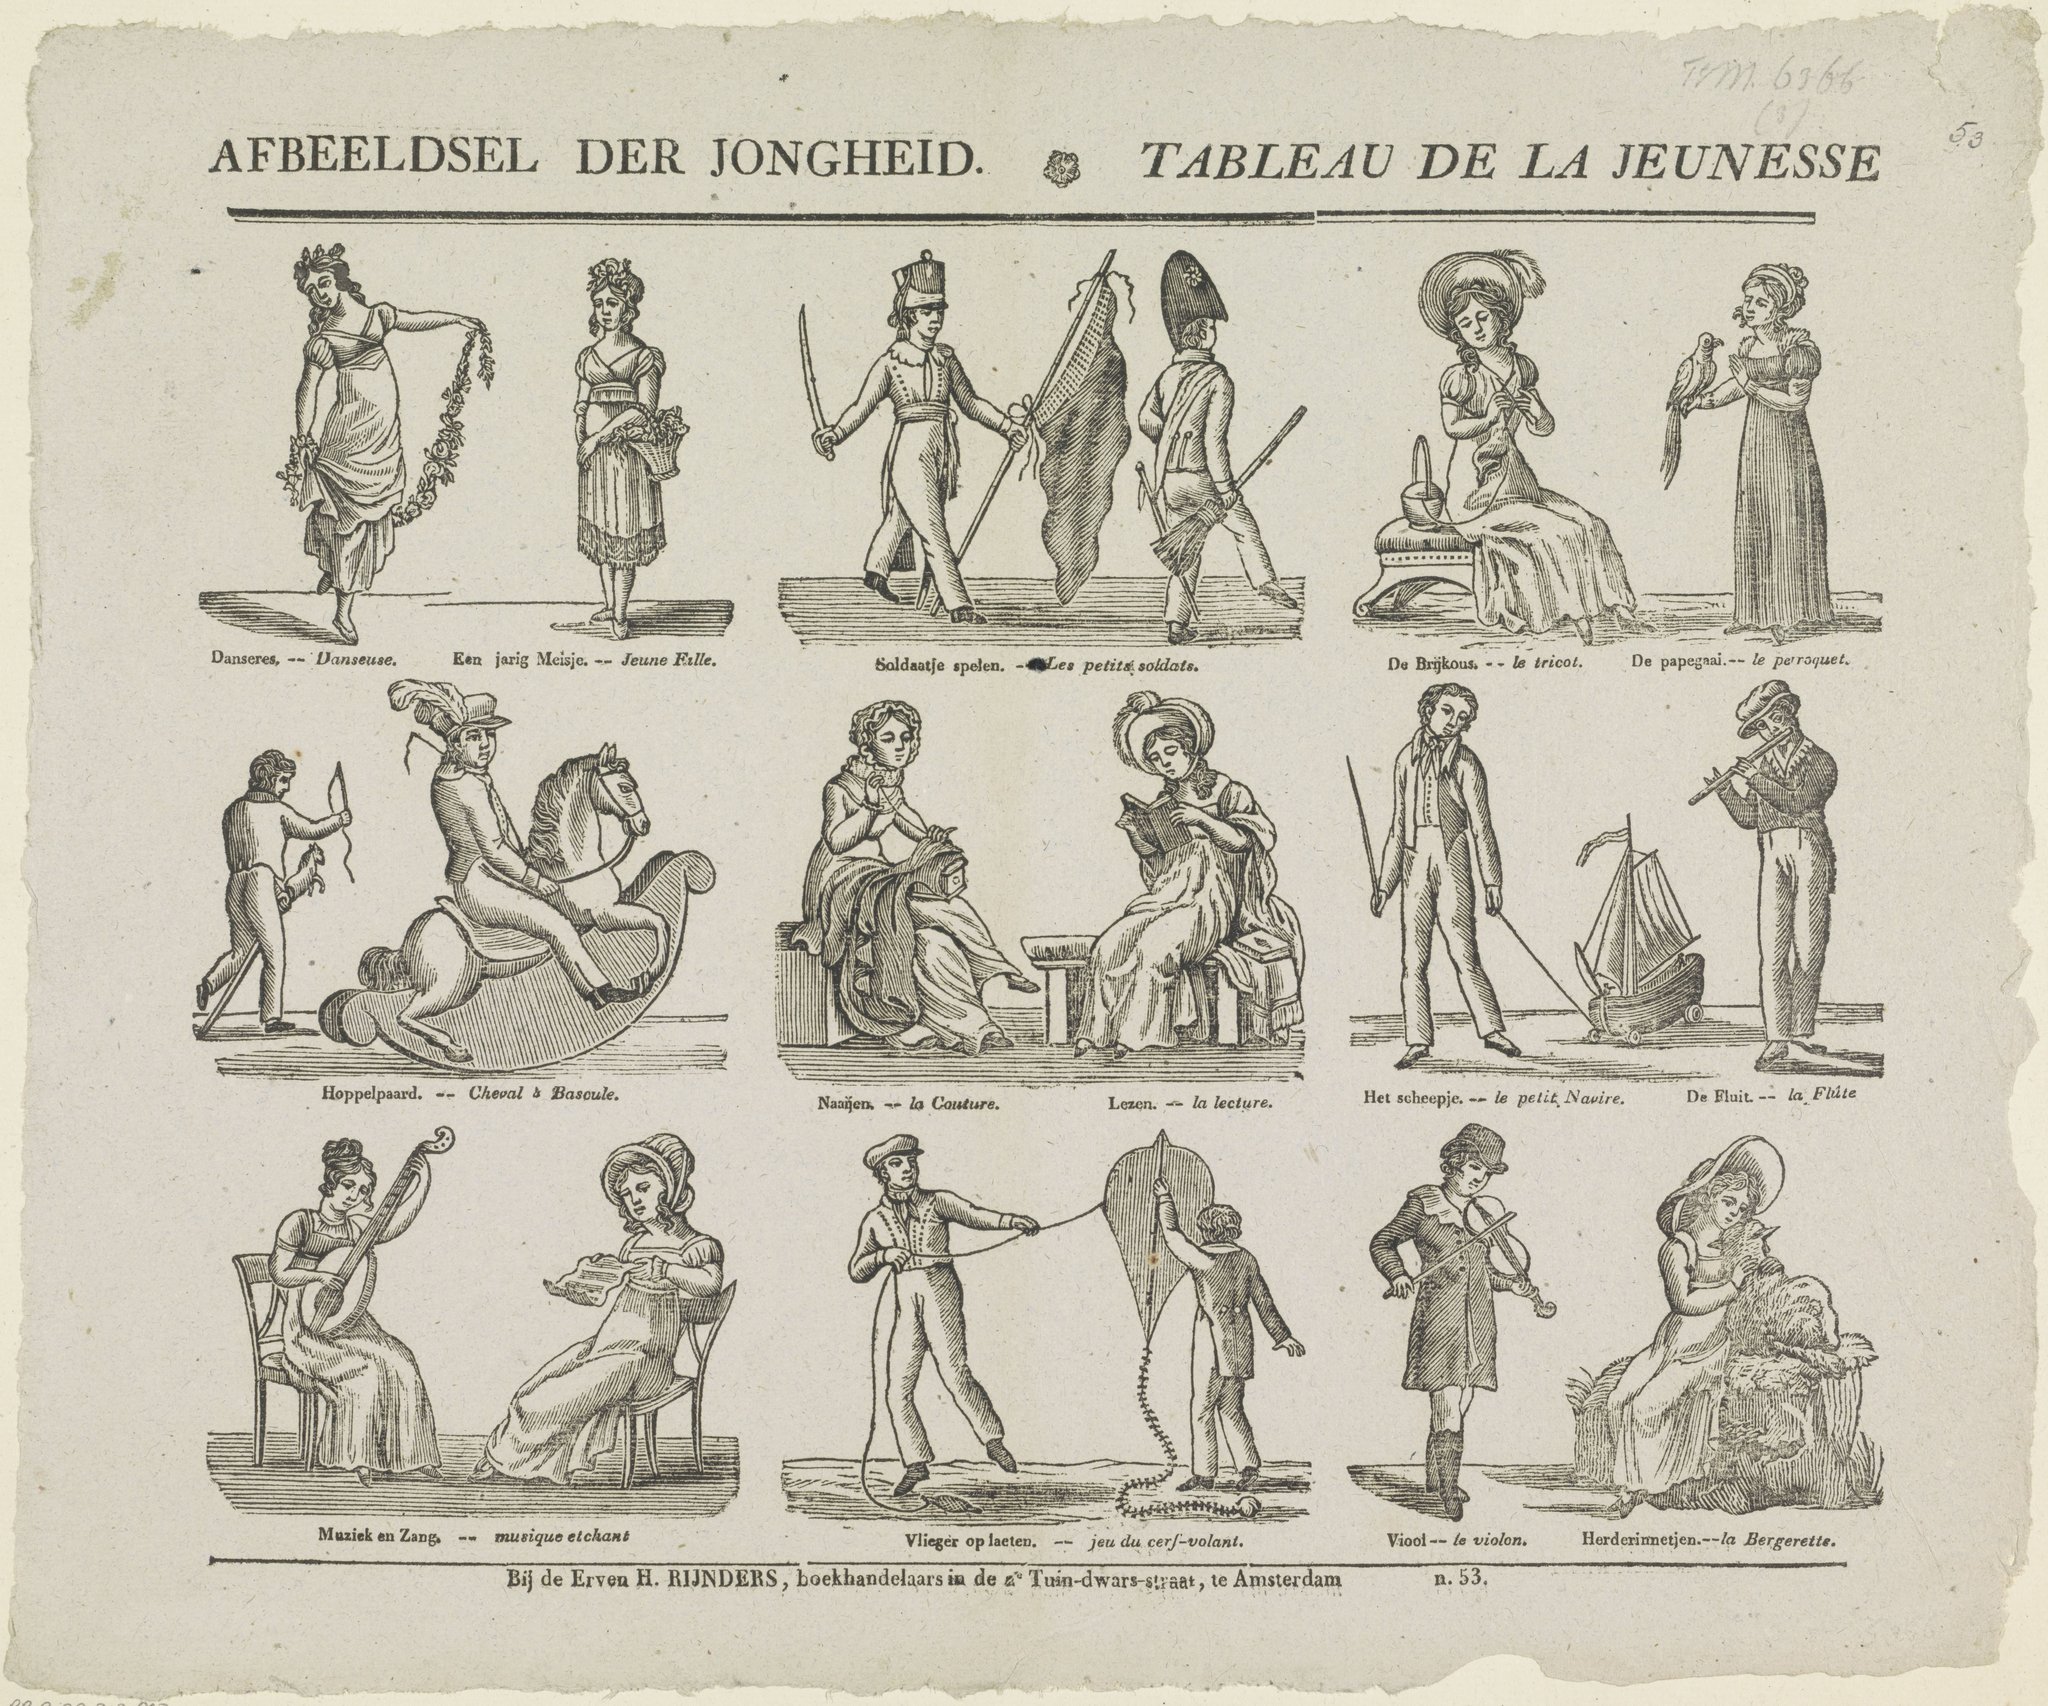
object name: popular print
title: Afbeeldsel der jongheid / Tableau de la jeunesse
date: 1800-1854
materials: paper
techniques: letterpress printing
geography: turnhout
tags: children's games and plays, dancing, (flying a) kite, rocking-horse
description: Blad met 9 voorstellingen van kinderspelen en bezigheden, waaronder dansen, soldaatje spelen en vliegeren. Onder elke afbeelding een onderschrift in het Nederlands en in het Frans. Genummerd rechtsonder: n. 53.